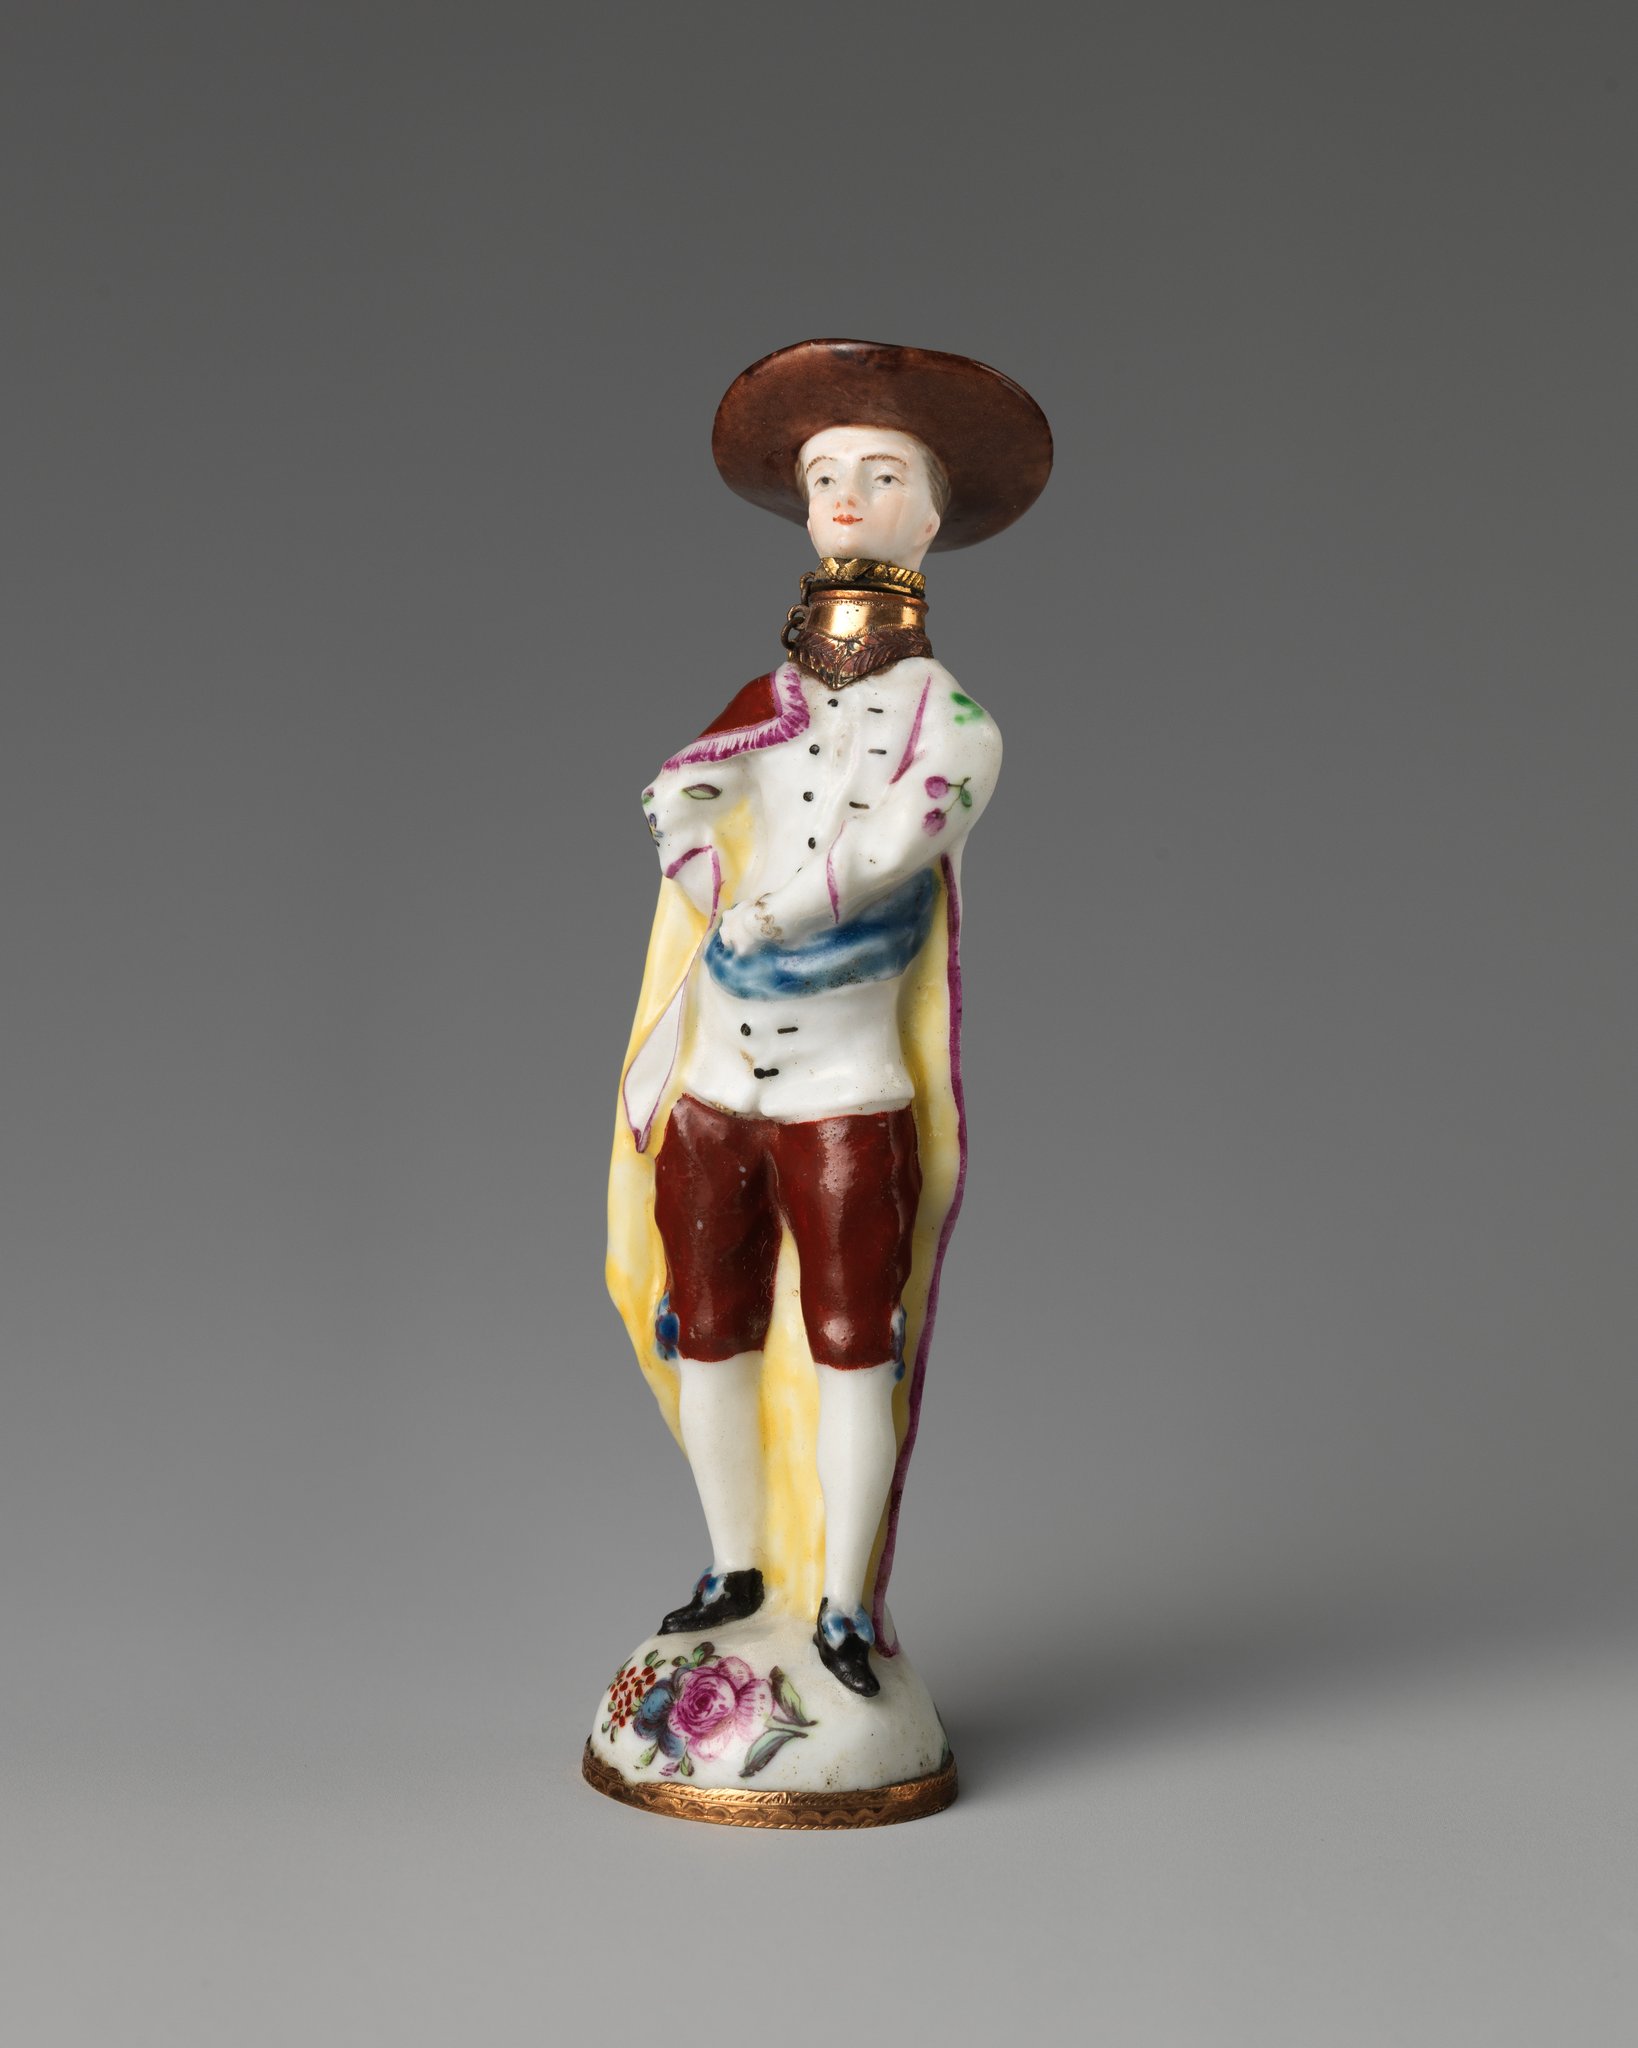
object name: toy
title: Troubadour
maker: saint james's factory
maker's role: maker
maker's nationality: british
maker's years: 1749-1759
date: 1750-1755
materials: soft paste porcelain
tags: men,poets